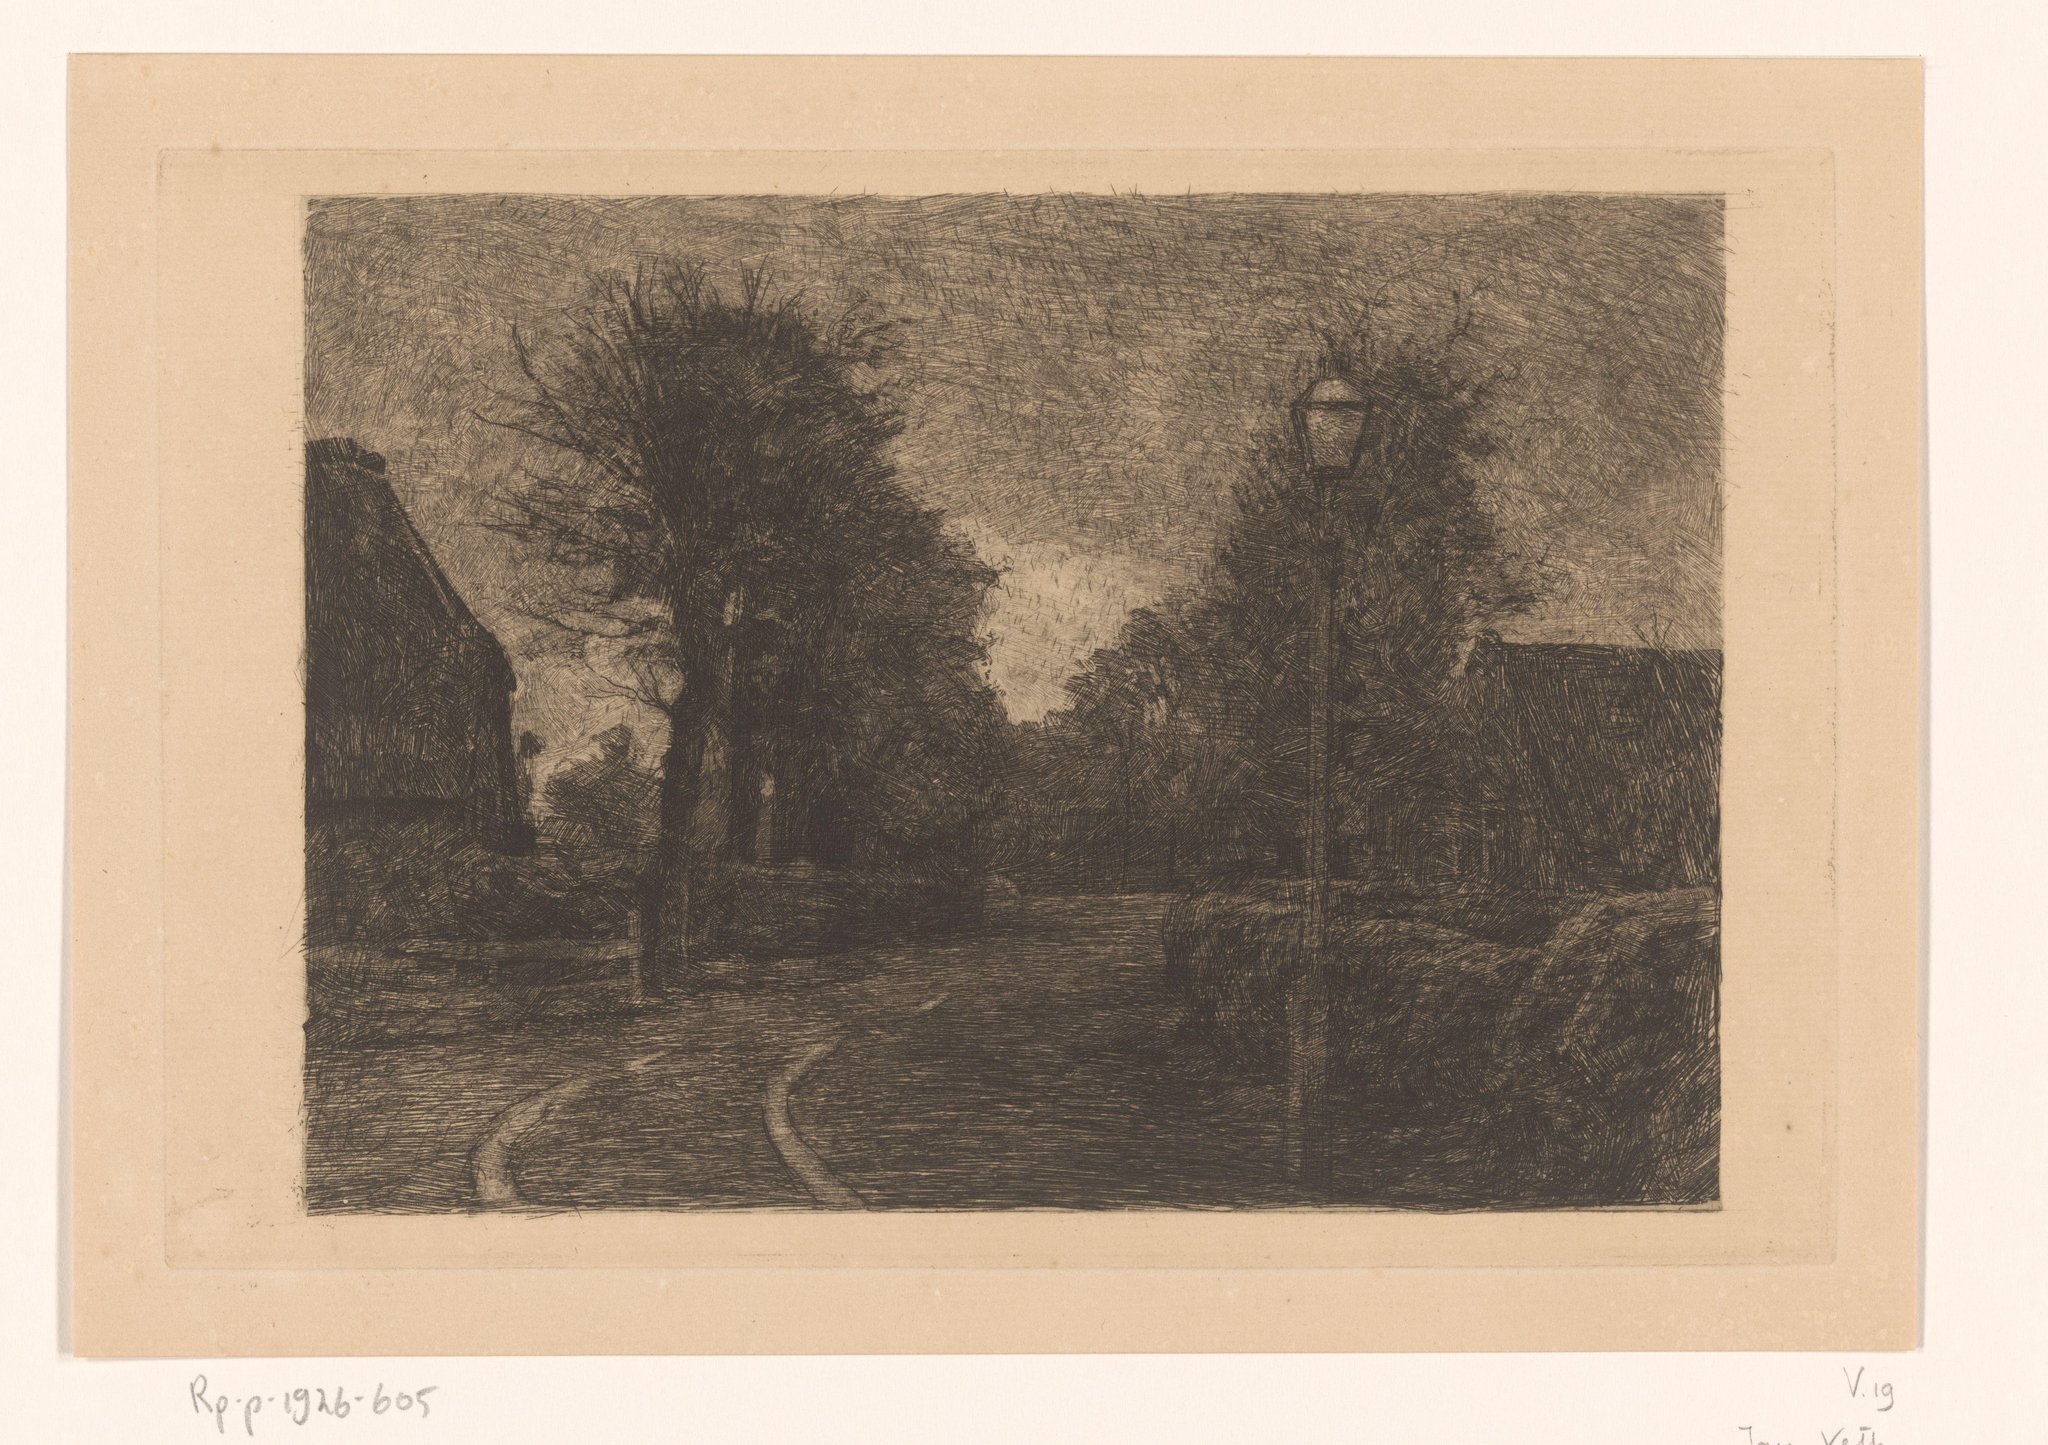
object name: print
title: Zevenend, Laren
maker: jan veth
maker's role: designer, draughtsman, painter, print maker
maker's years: 1864-1925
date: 1886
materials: paper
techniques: etching, intaglio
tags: village, street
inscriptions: collector's mark: Lugt 2228